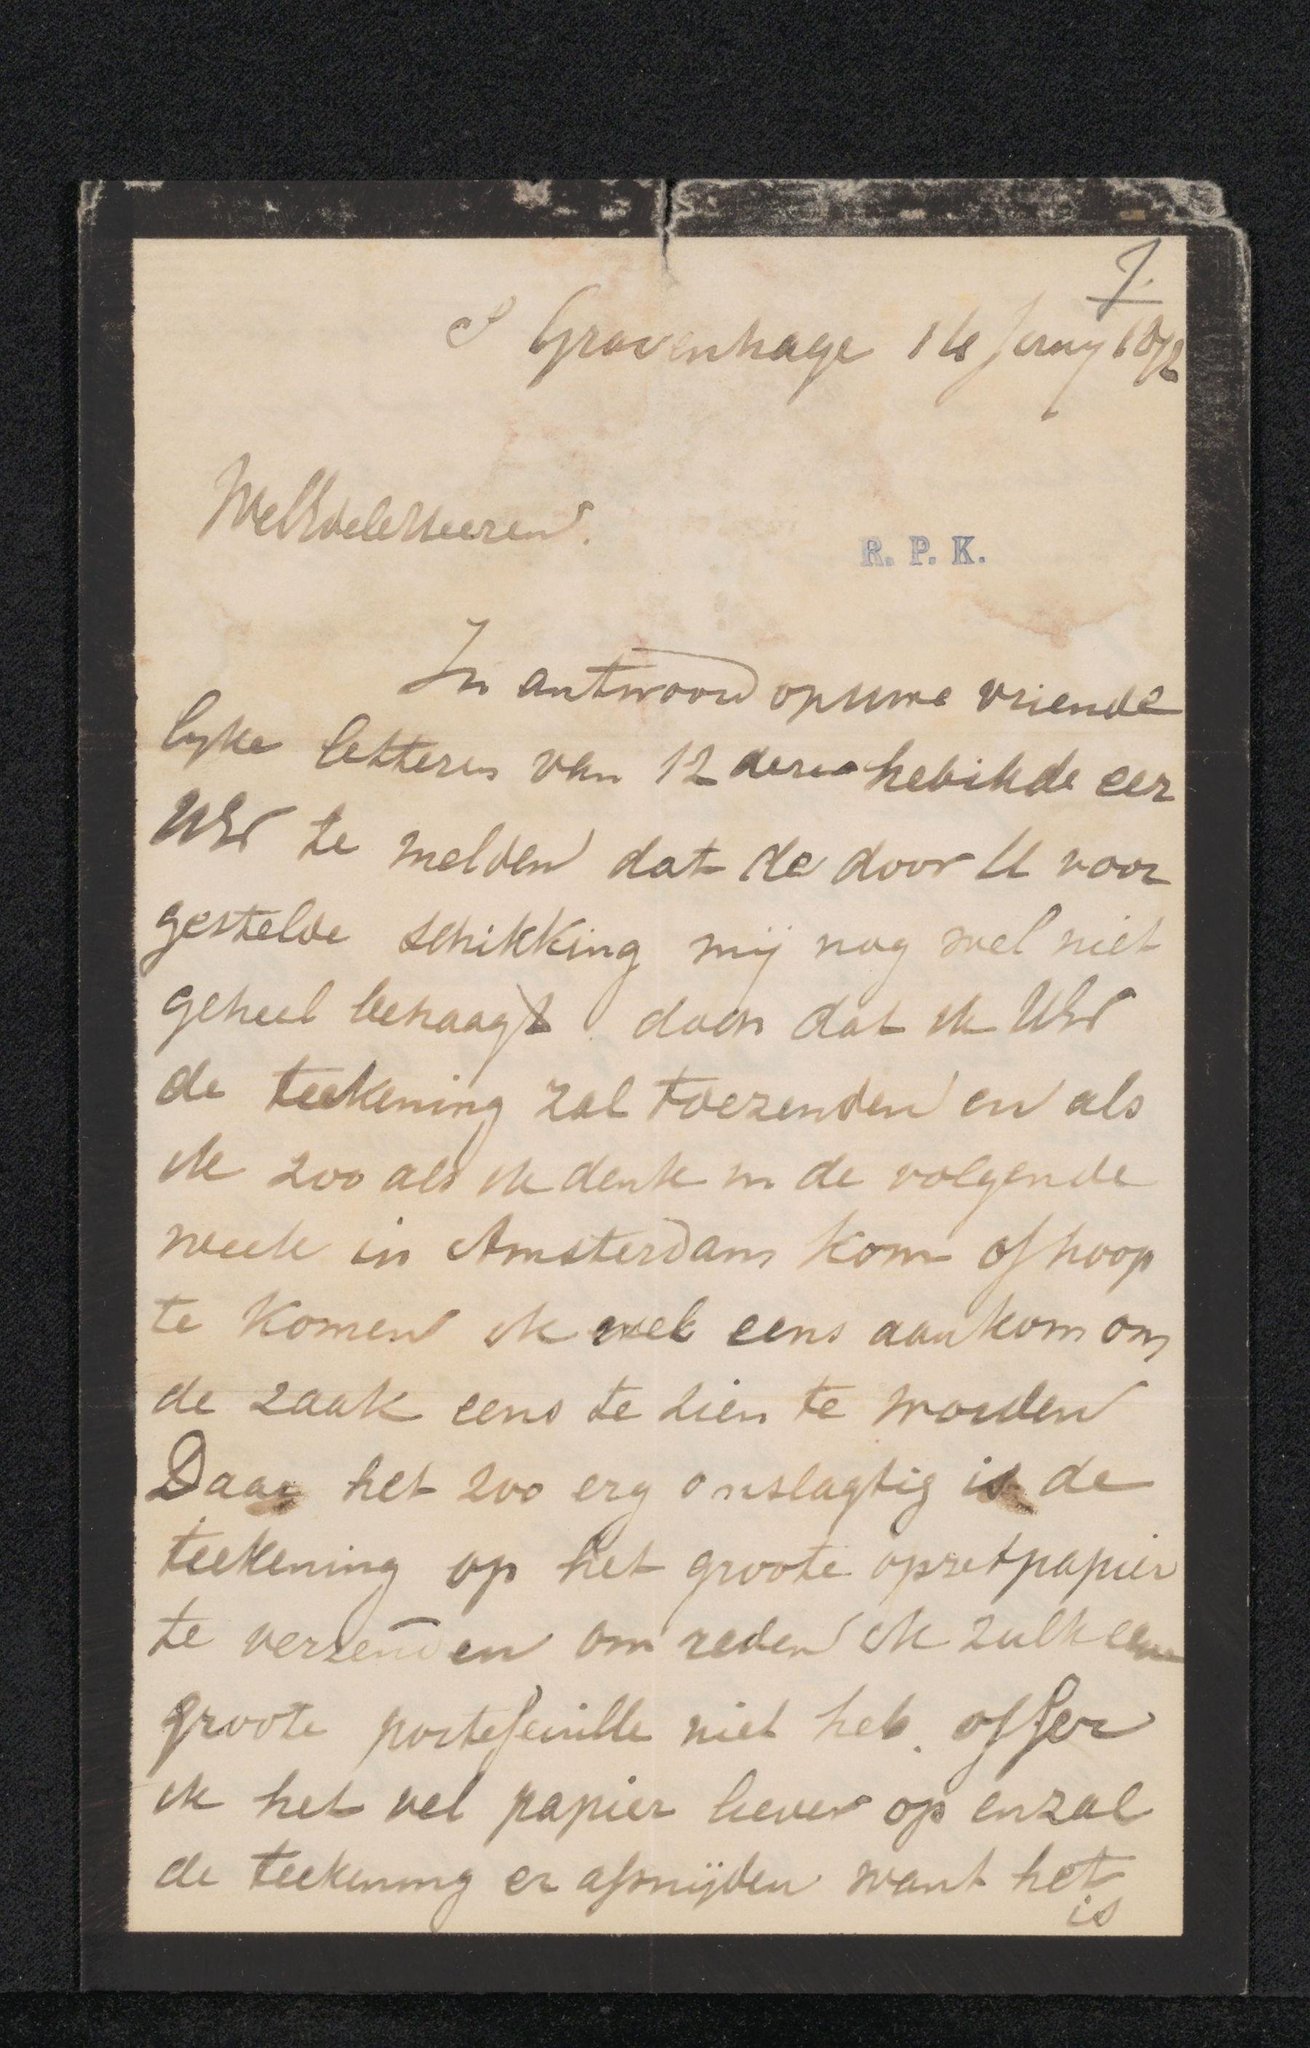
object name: letter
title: Brief aan Frans Buffa en Zonen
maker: pieter stortenbeker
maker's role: draughtsman, painter, print maker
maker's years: 1828-1898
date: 1872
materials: ink, paper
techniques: pen, writing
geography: the hague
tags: bernardus johannes blommers, publisher, art trade, art shop, drawing, exhibition ~ art, money, amsterdam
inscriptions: collector's mark: Lugt 2233